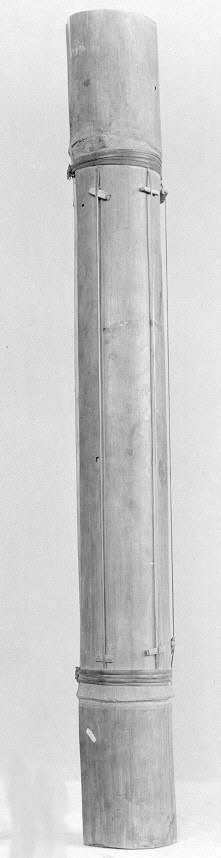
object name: tang kang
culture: bornean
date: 1867-1900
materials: bamboo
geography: borneo